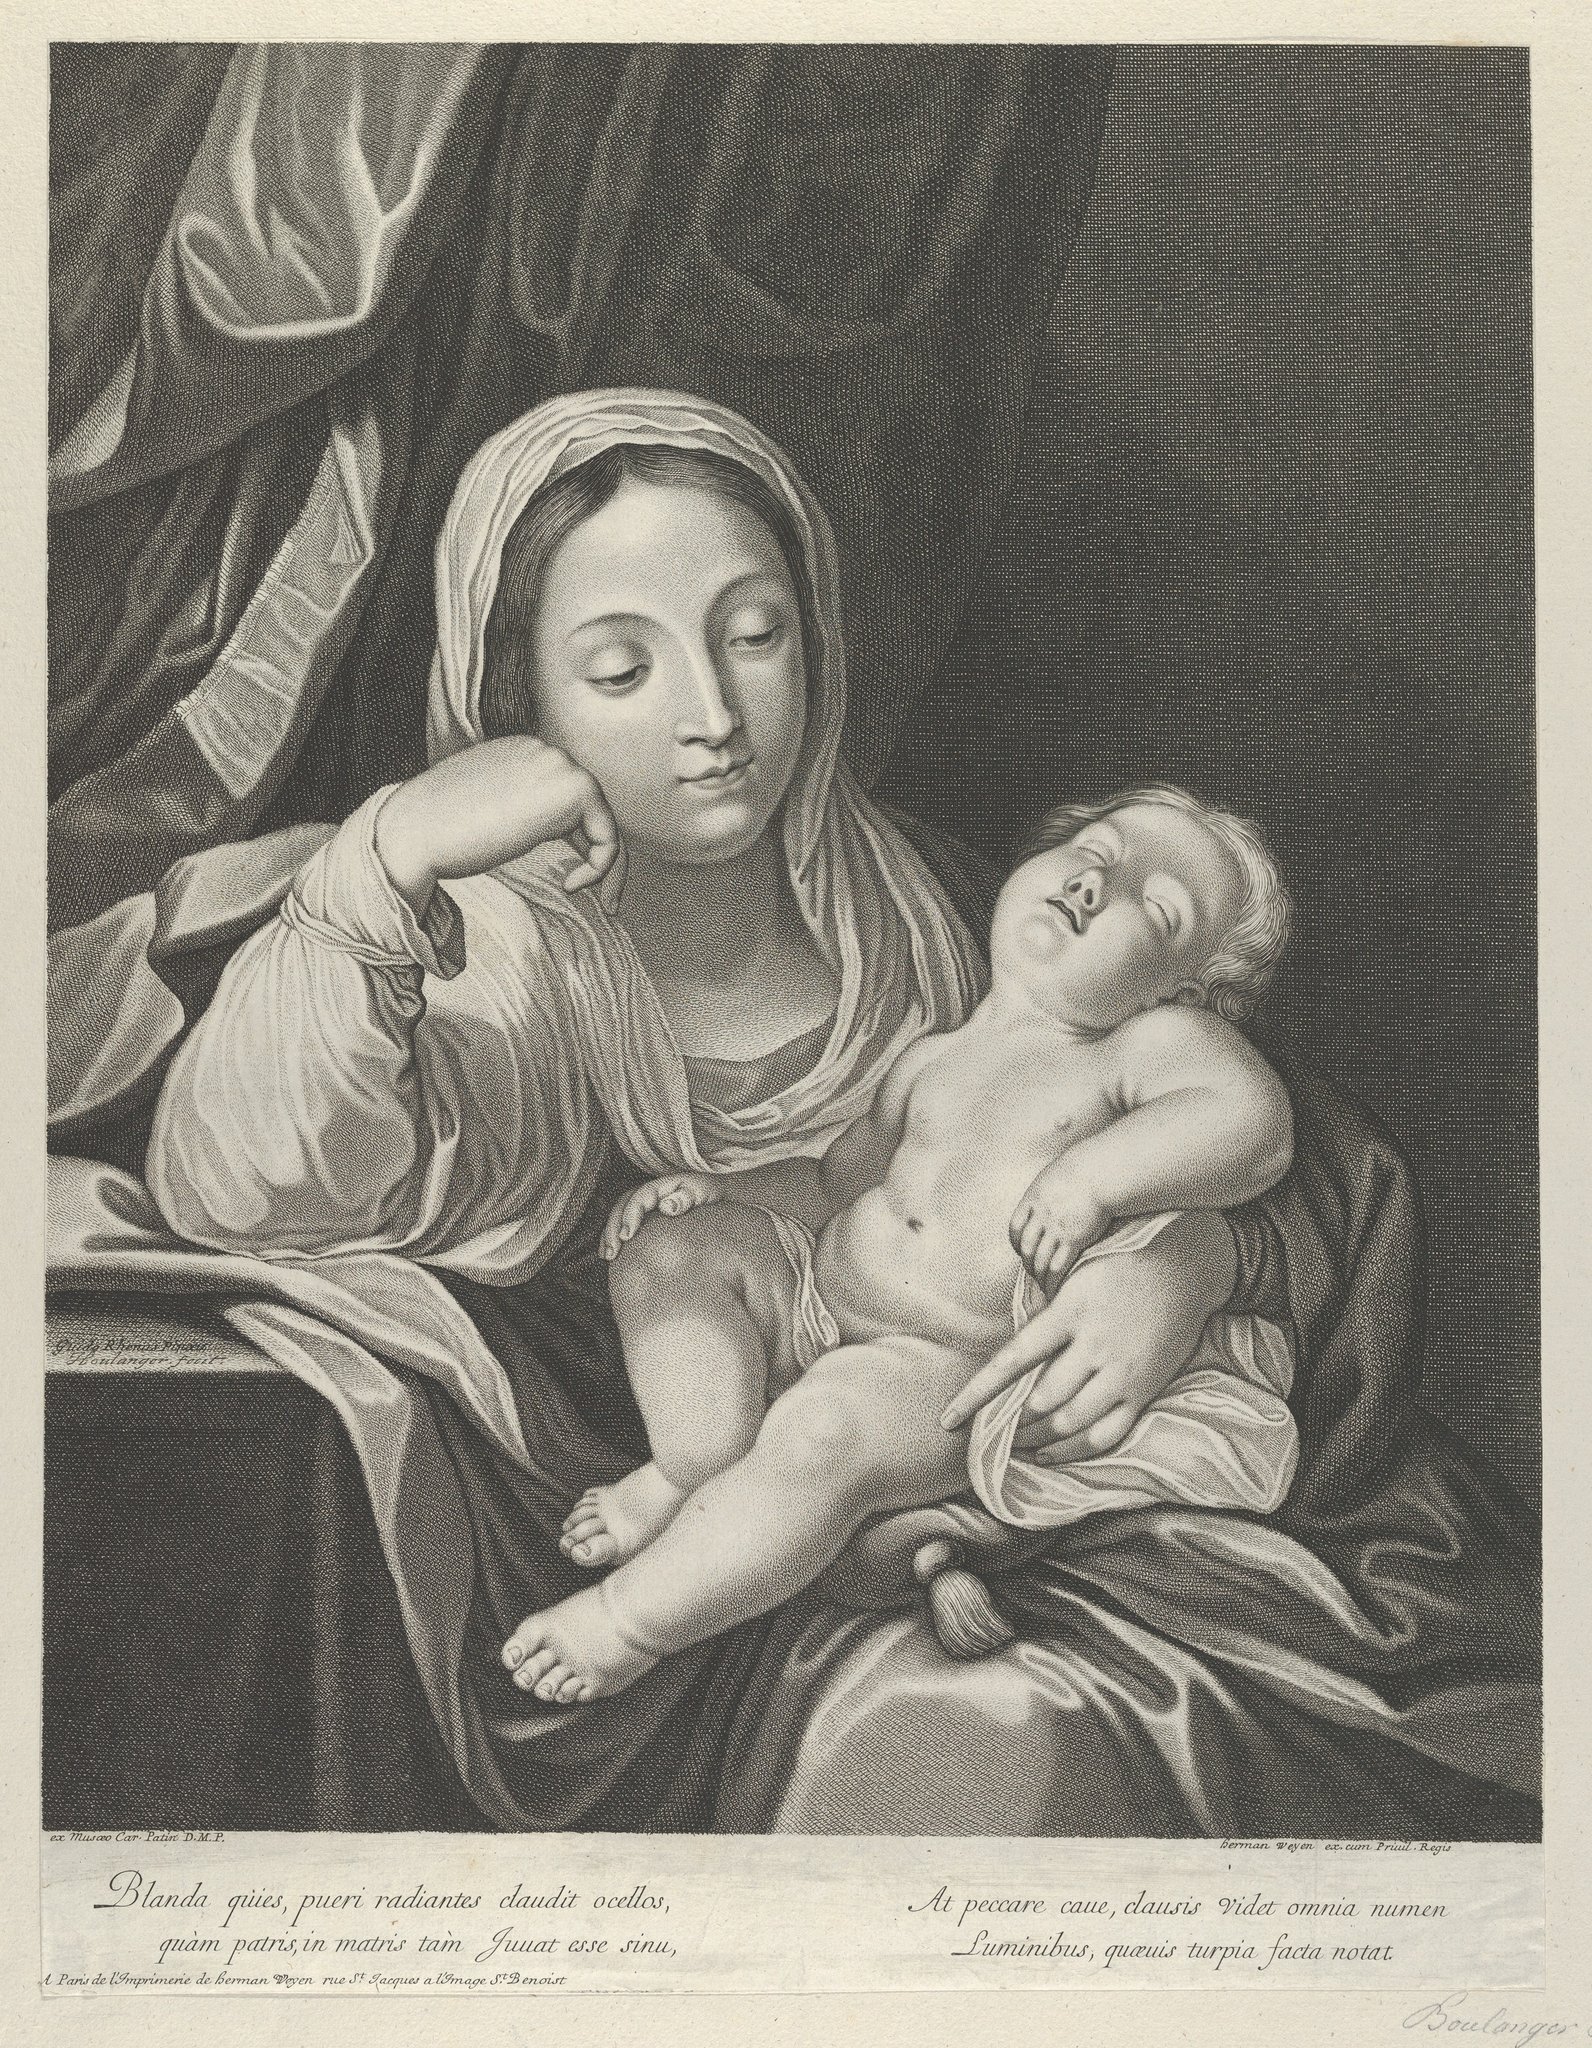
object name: print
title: The Virgin seated with her head resting on her right hand, holding the sleeping infant Christ on her lap, after Reni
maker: jean boulanger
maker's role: artist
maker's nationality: french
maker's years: 1608-1685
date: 1623-1680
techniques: engraving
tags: madonna and child